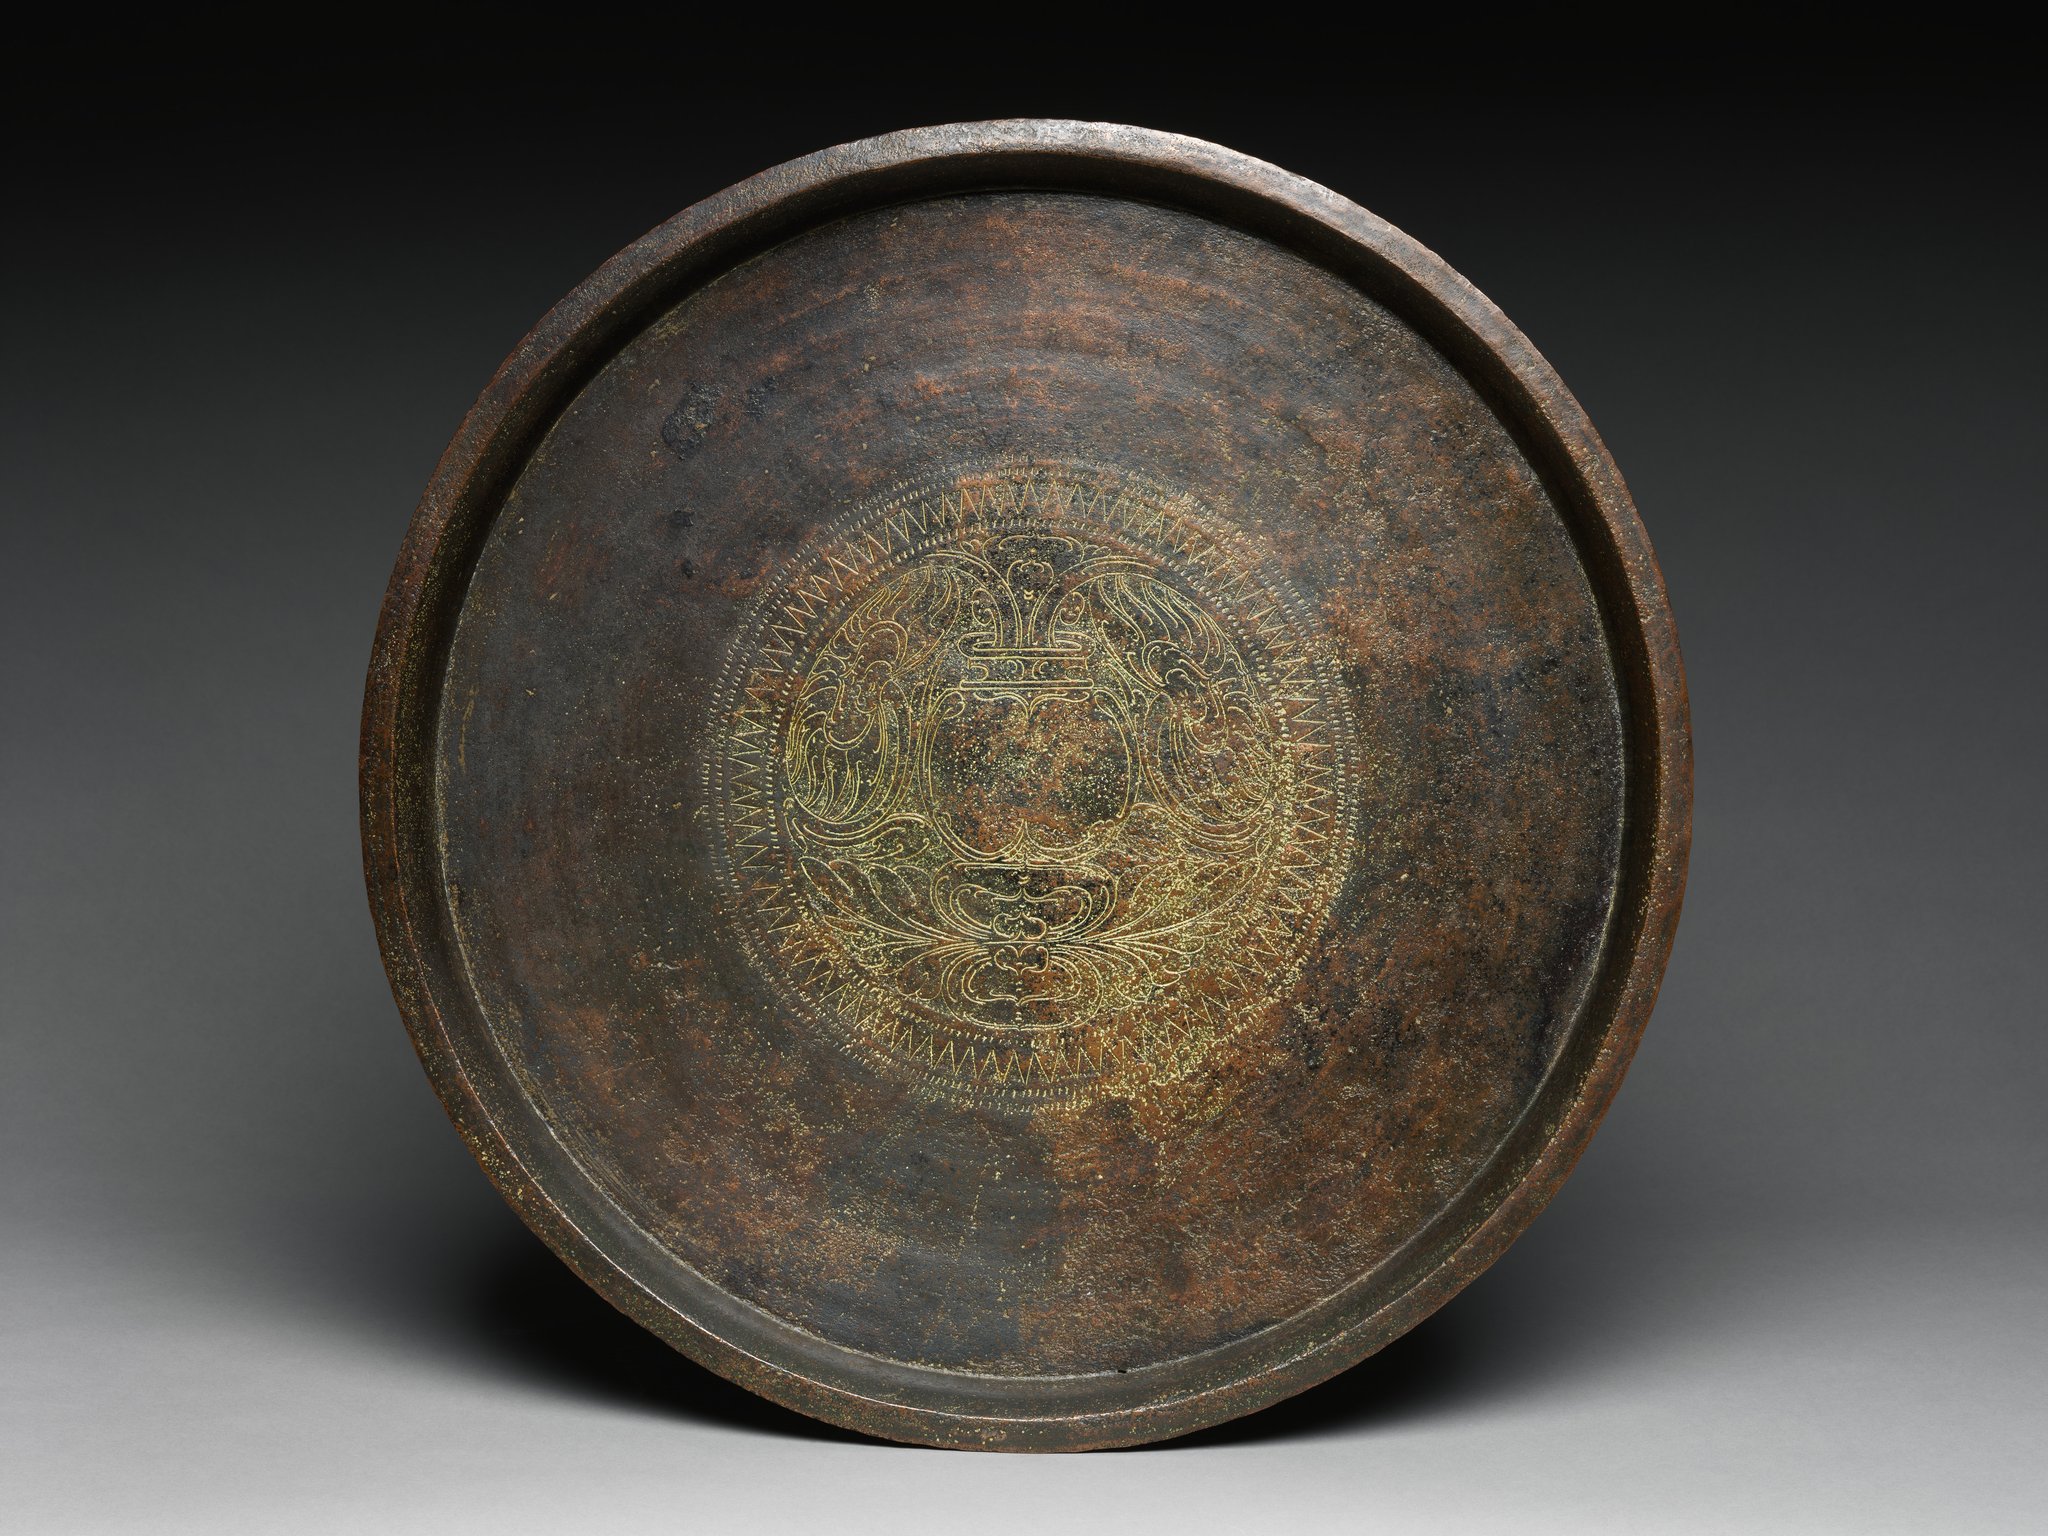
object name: tray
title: Offering tray (talam)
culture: indonesian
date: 1101-1400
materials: copper alloy